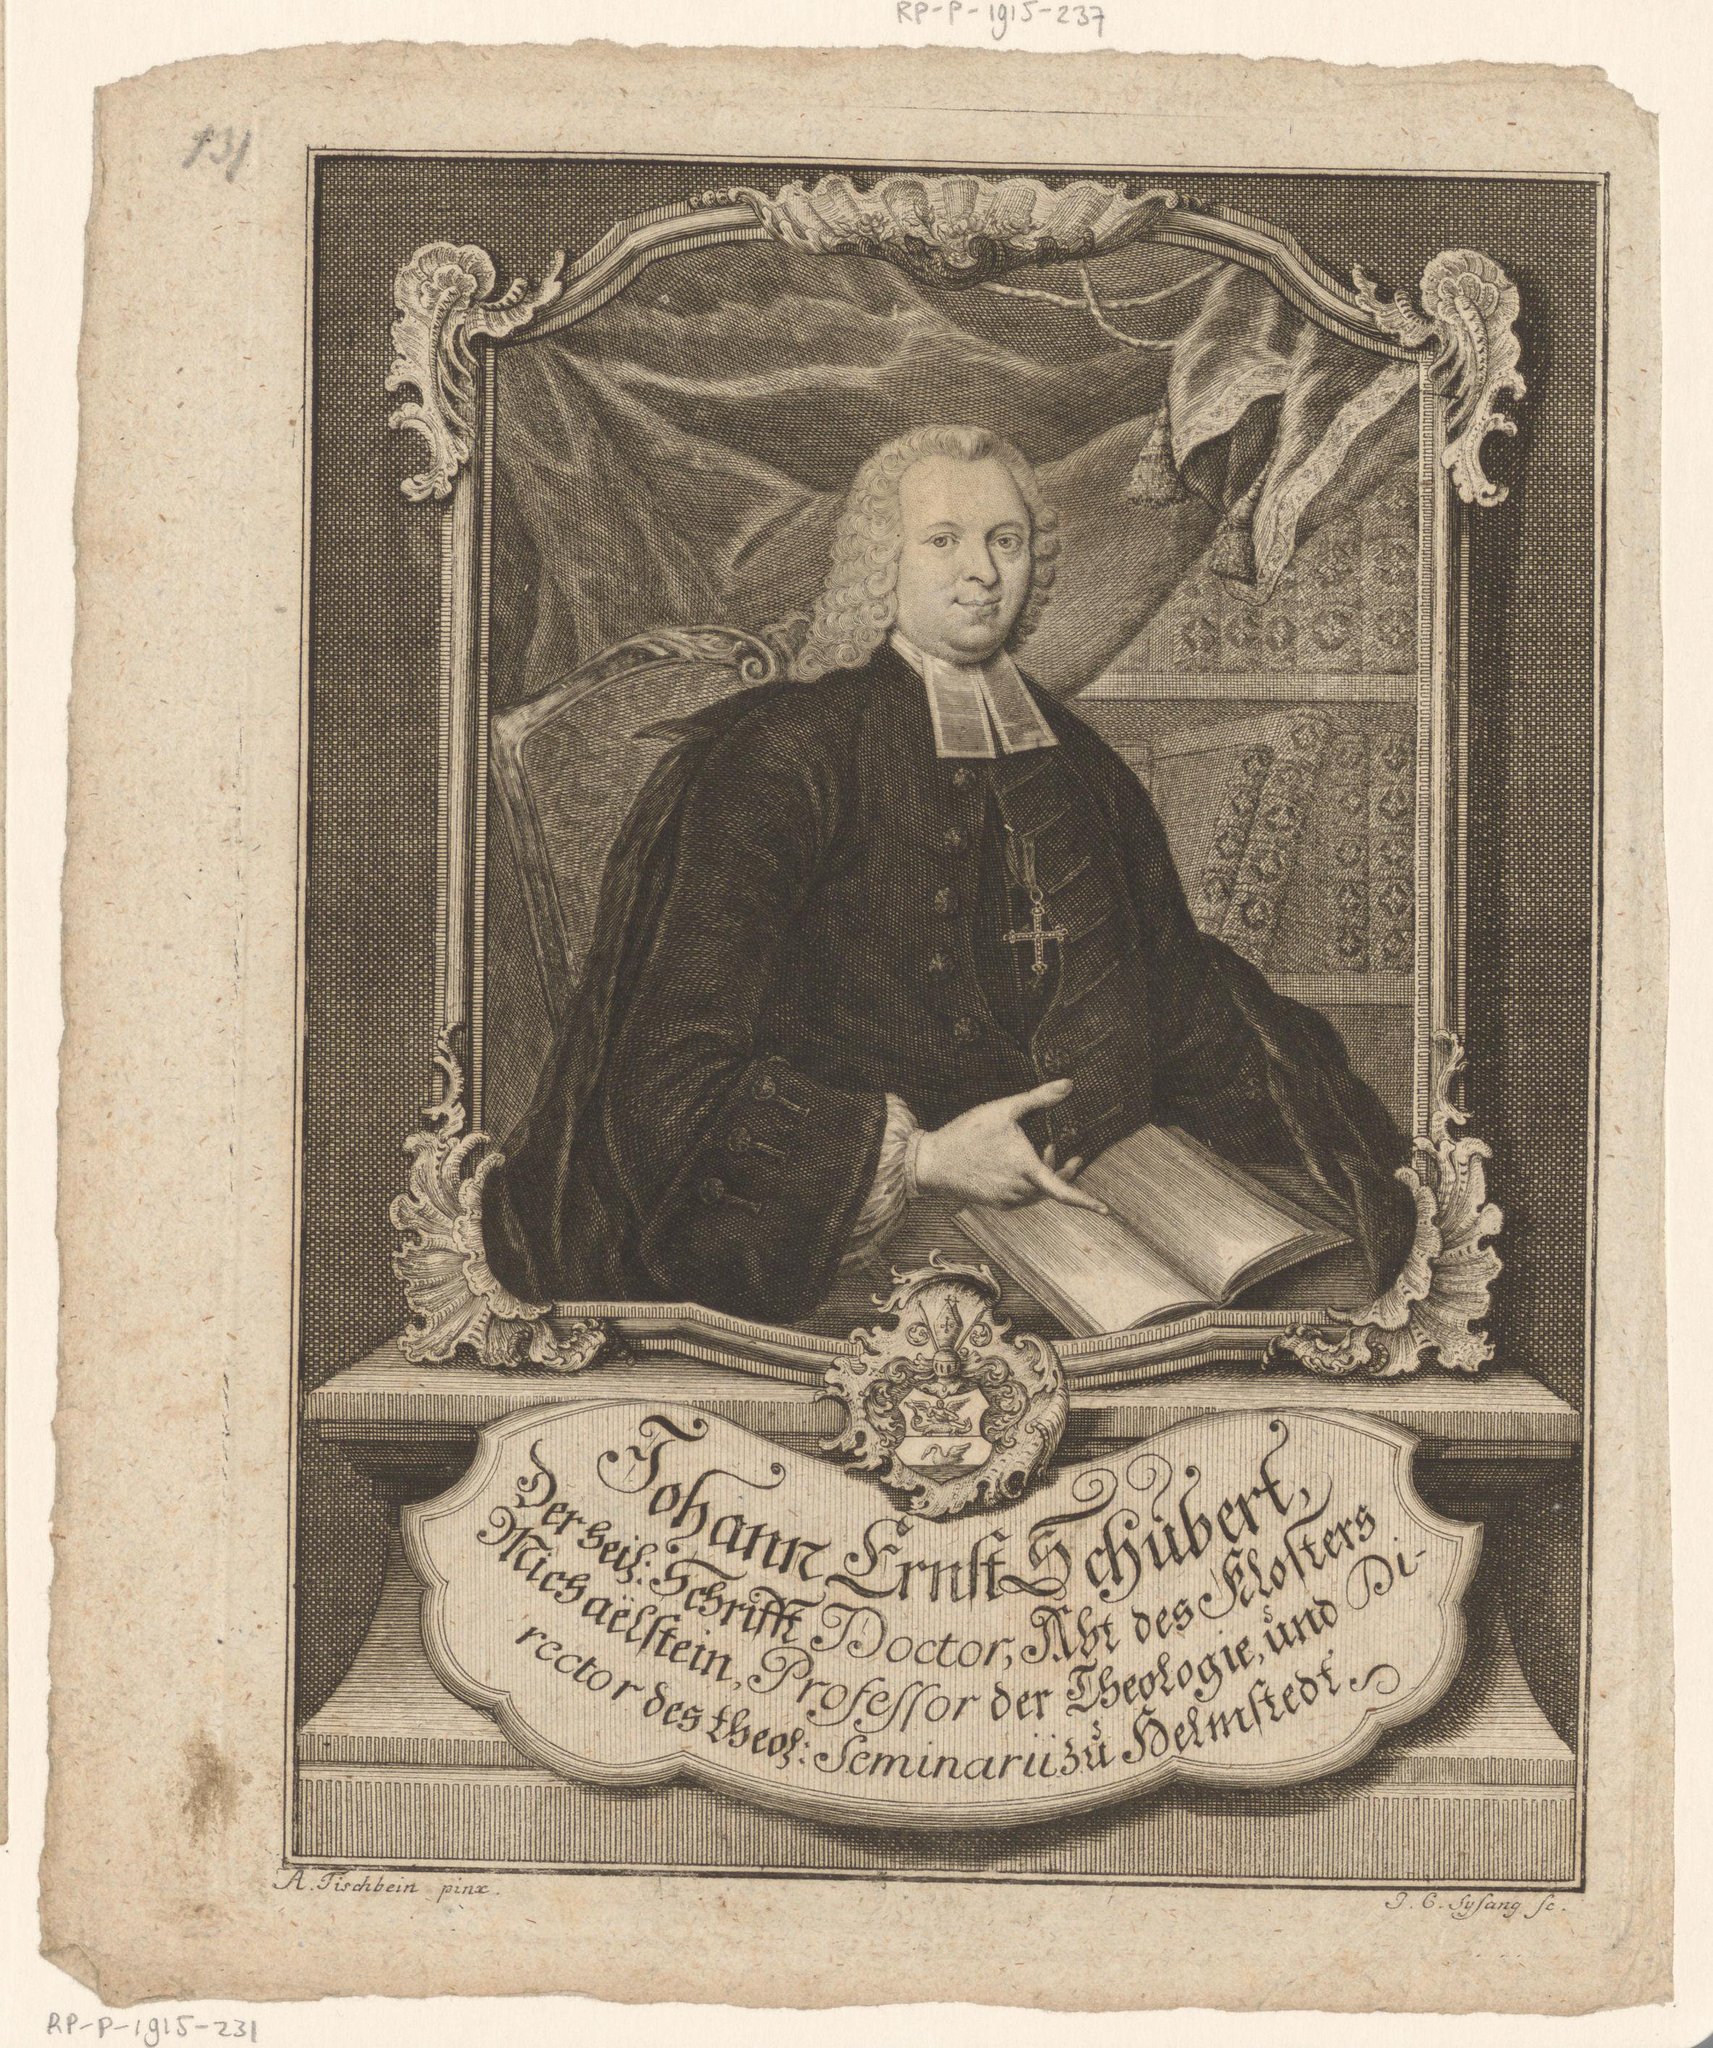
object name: print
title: Portret van Johann Ernst Schubert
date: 1748-1757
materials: paper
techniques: engraving, etching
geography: leipzig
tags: bookshelves, historical persons, book, armorial bearing, heraldry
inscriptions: collector's mark: Lugt 2228